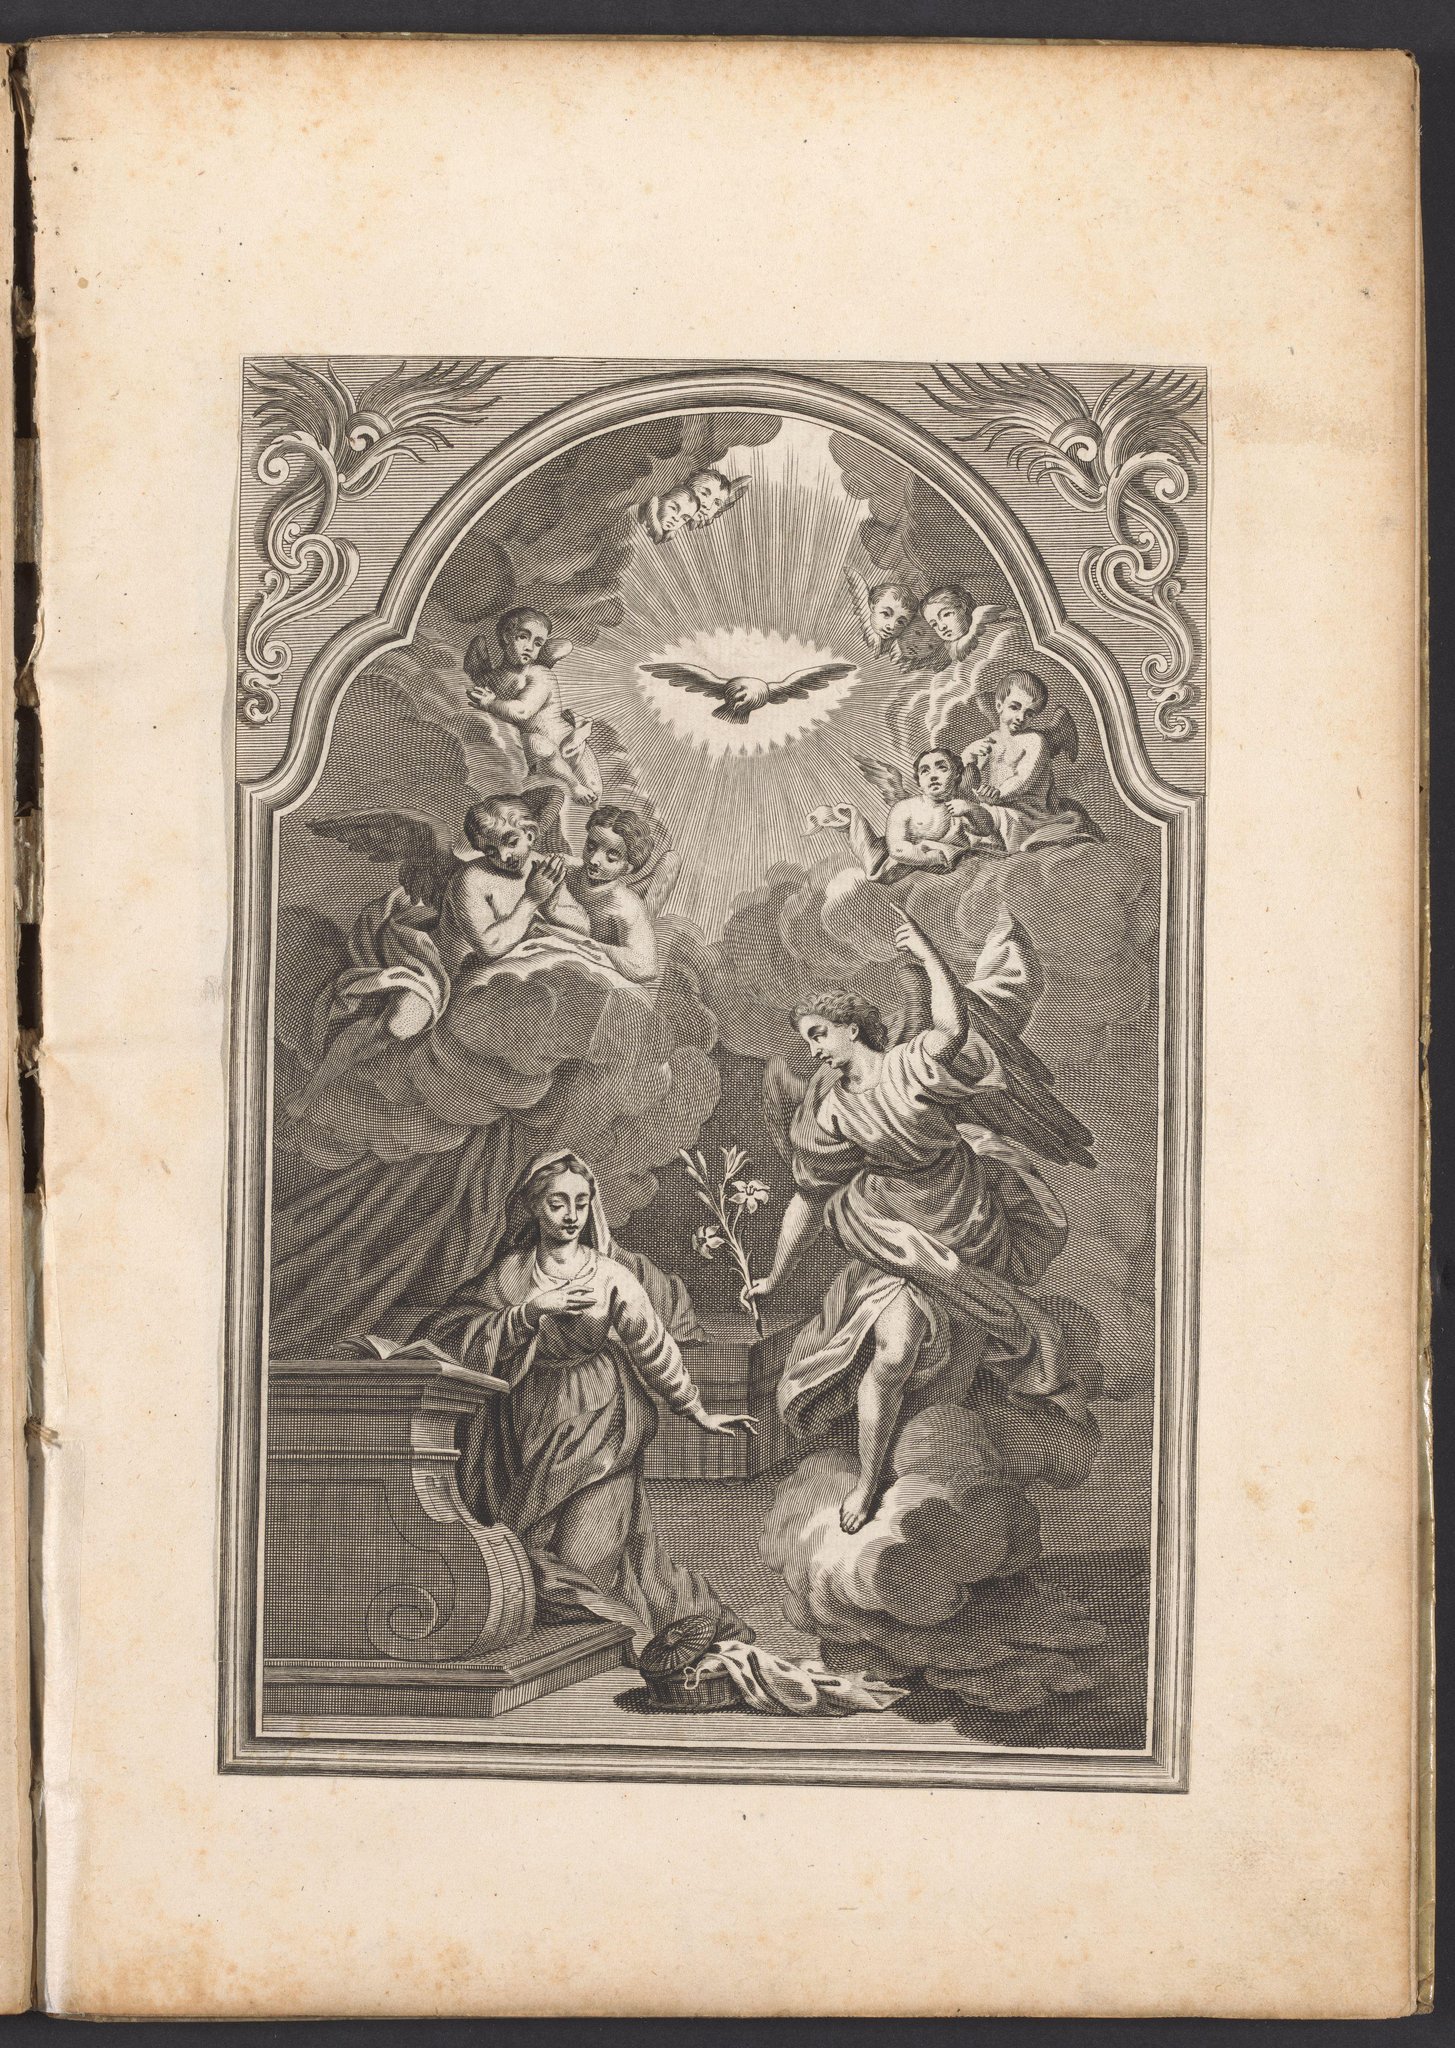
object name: print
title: Annunciatie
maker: Anonymous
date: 1600-1699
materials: paper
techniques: engraving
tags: the annunciation: mary kneeling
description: Deze prent maakt deel uit van een album.